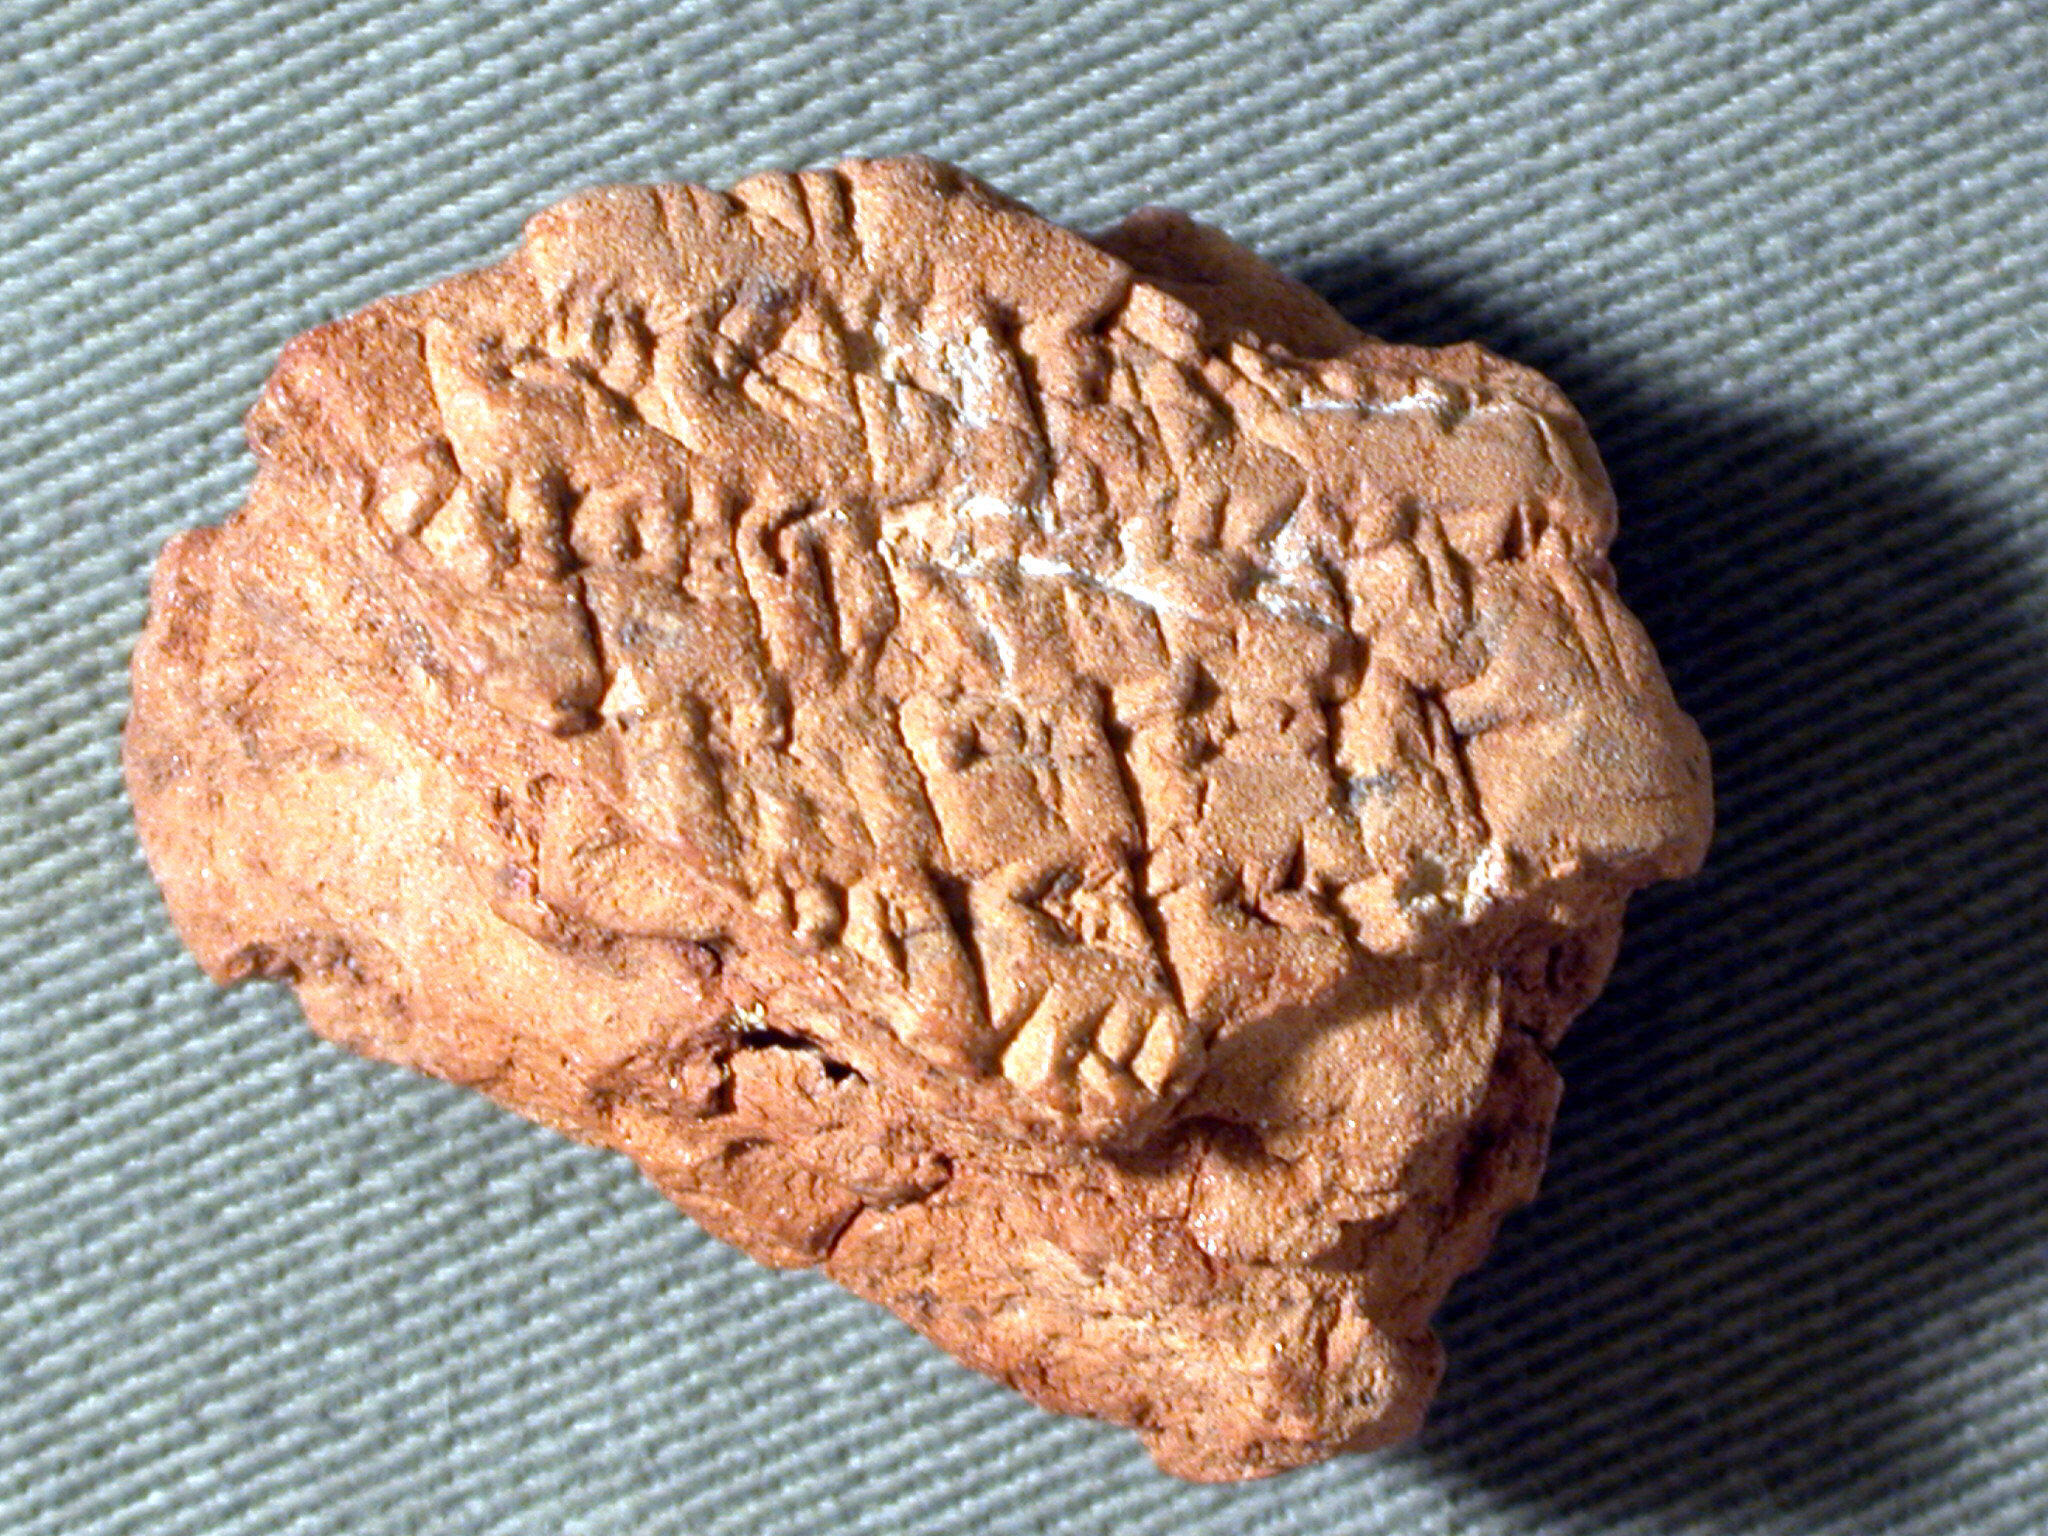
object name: cuneiform tablet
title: Cuneiform tablet: fragment of a contract (?)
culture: achaemenid or babylonian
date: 700-301 BCE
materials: clay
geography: mesopotamia